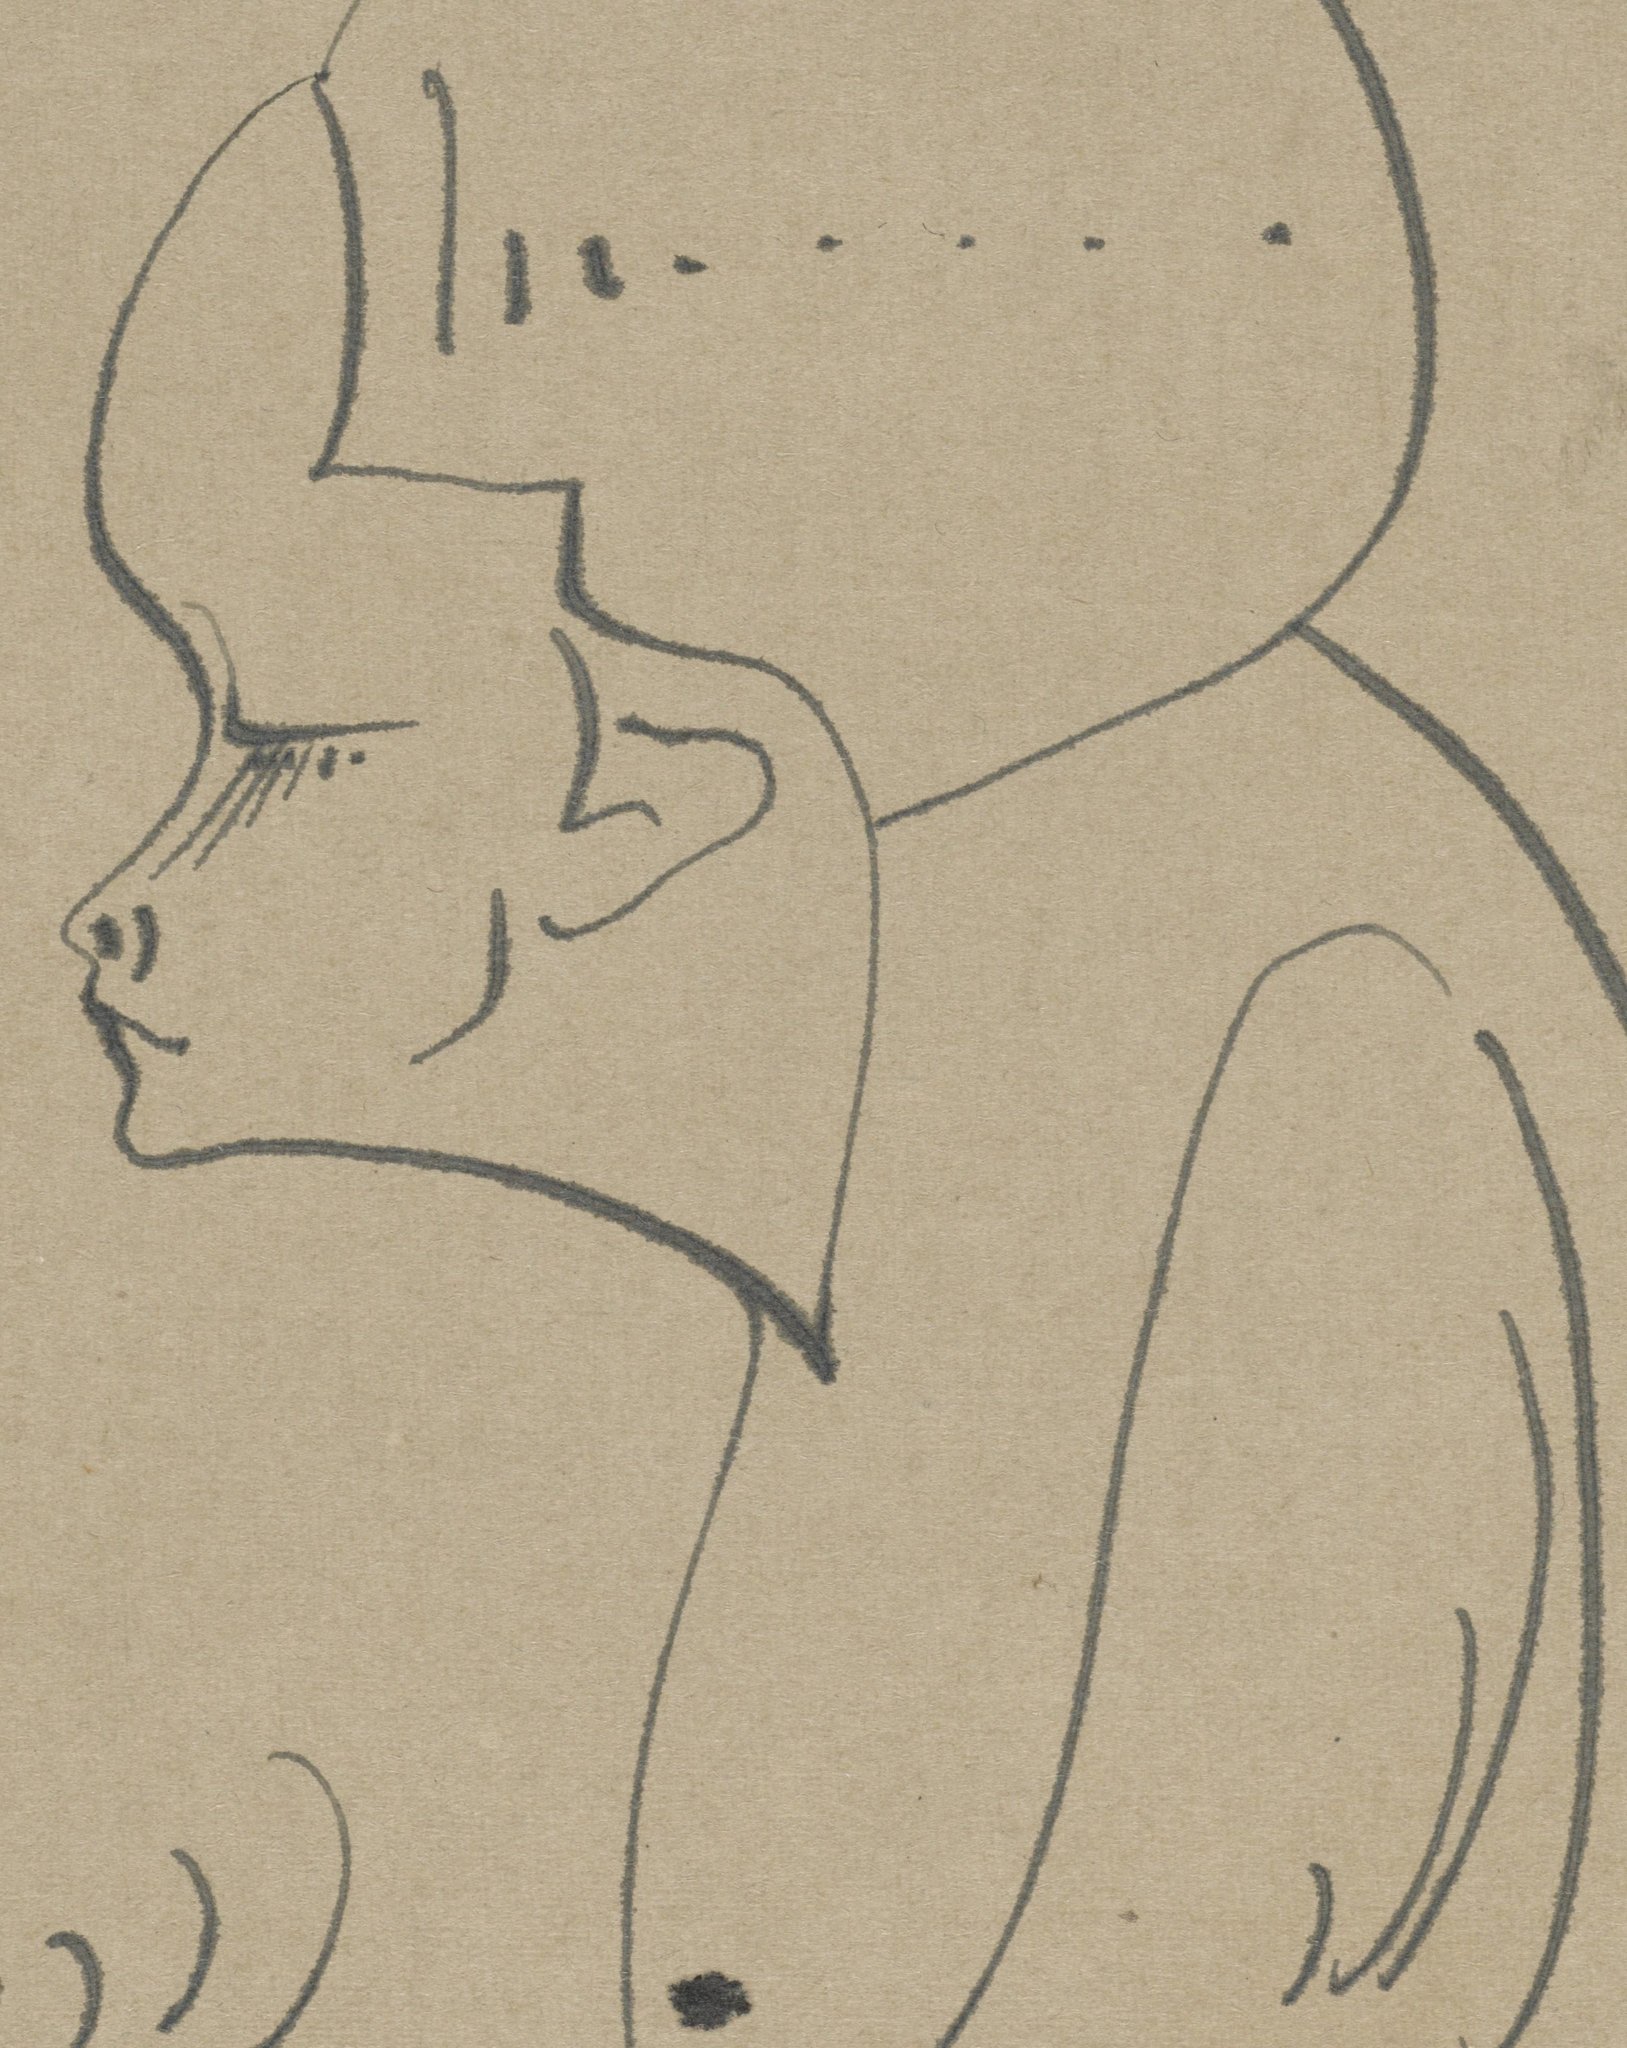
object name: drawing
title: Hoofd, in profiel naar links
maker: samuel jessurun de mesquita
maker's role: draughtsman, print maker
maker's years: 1868-1944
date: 1878-1944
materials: ink, paper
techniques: pen